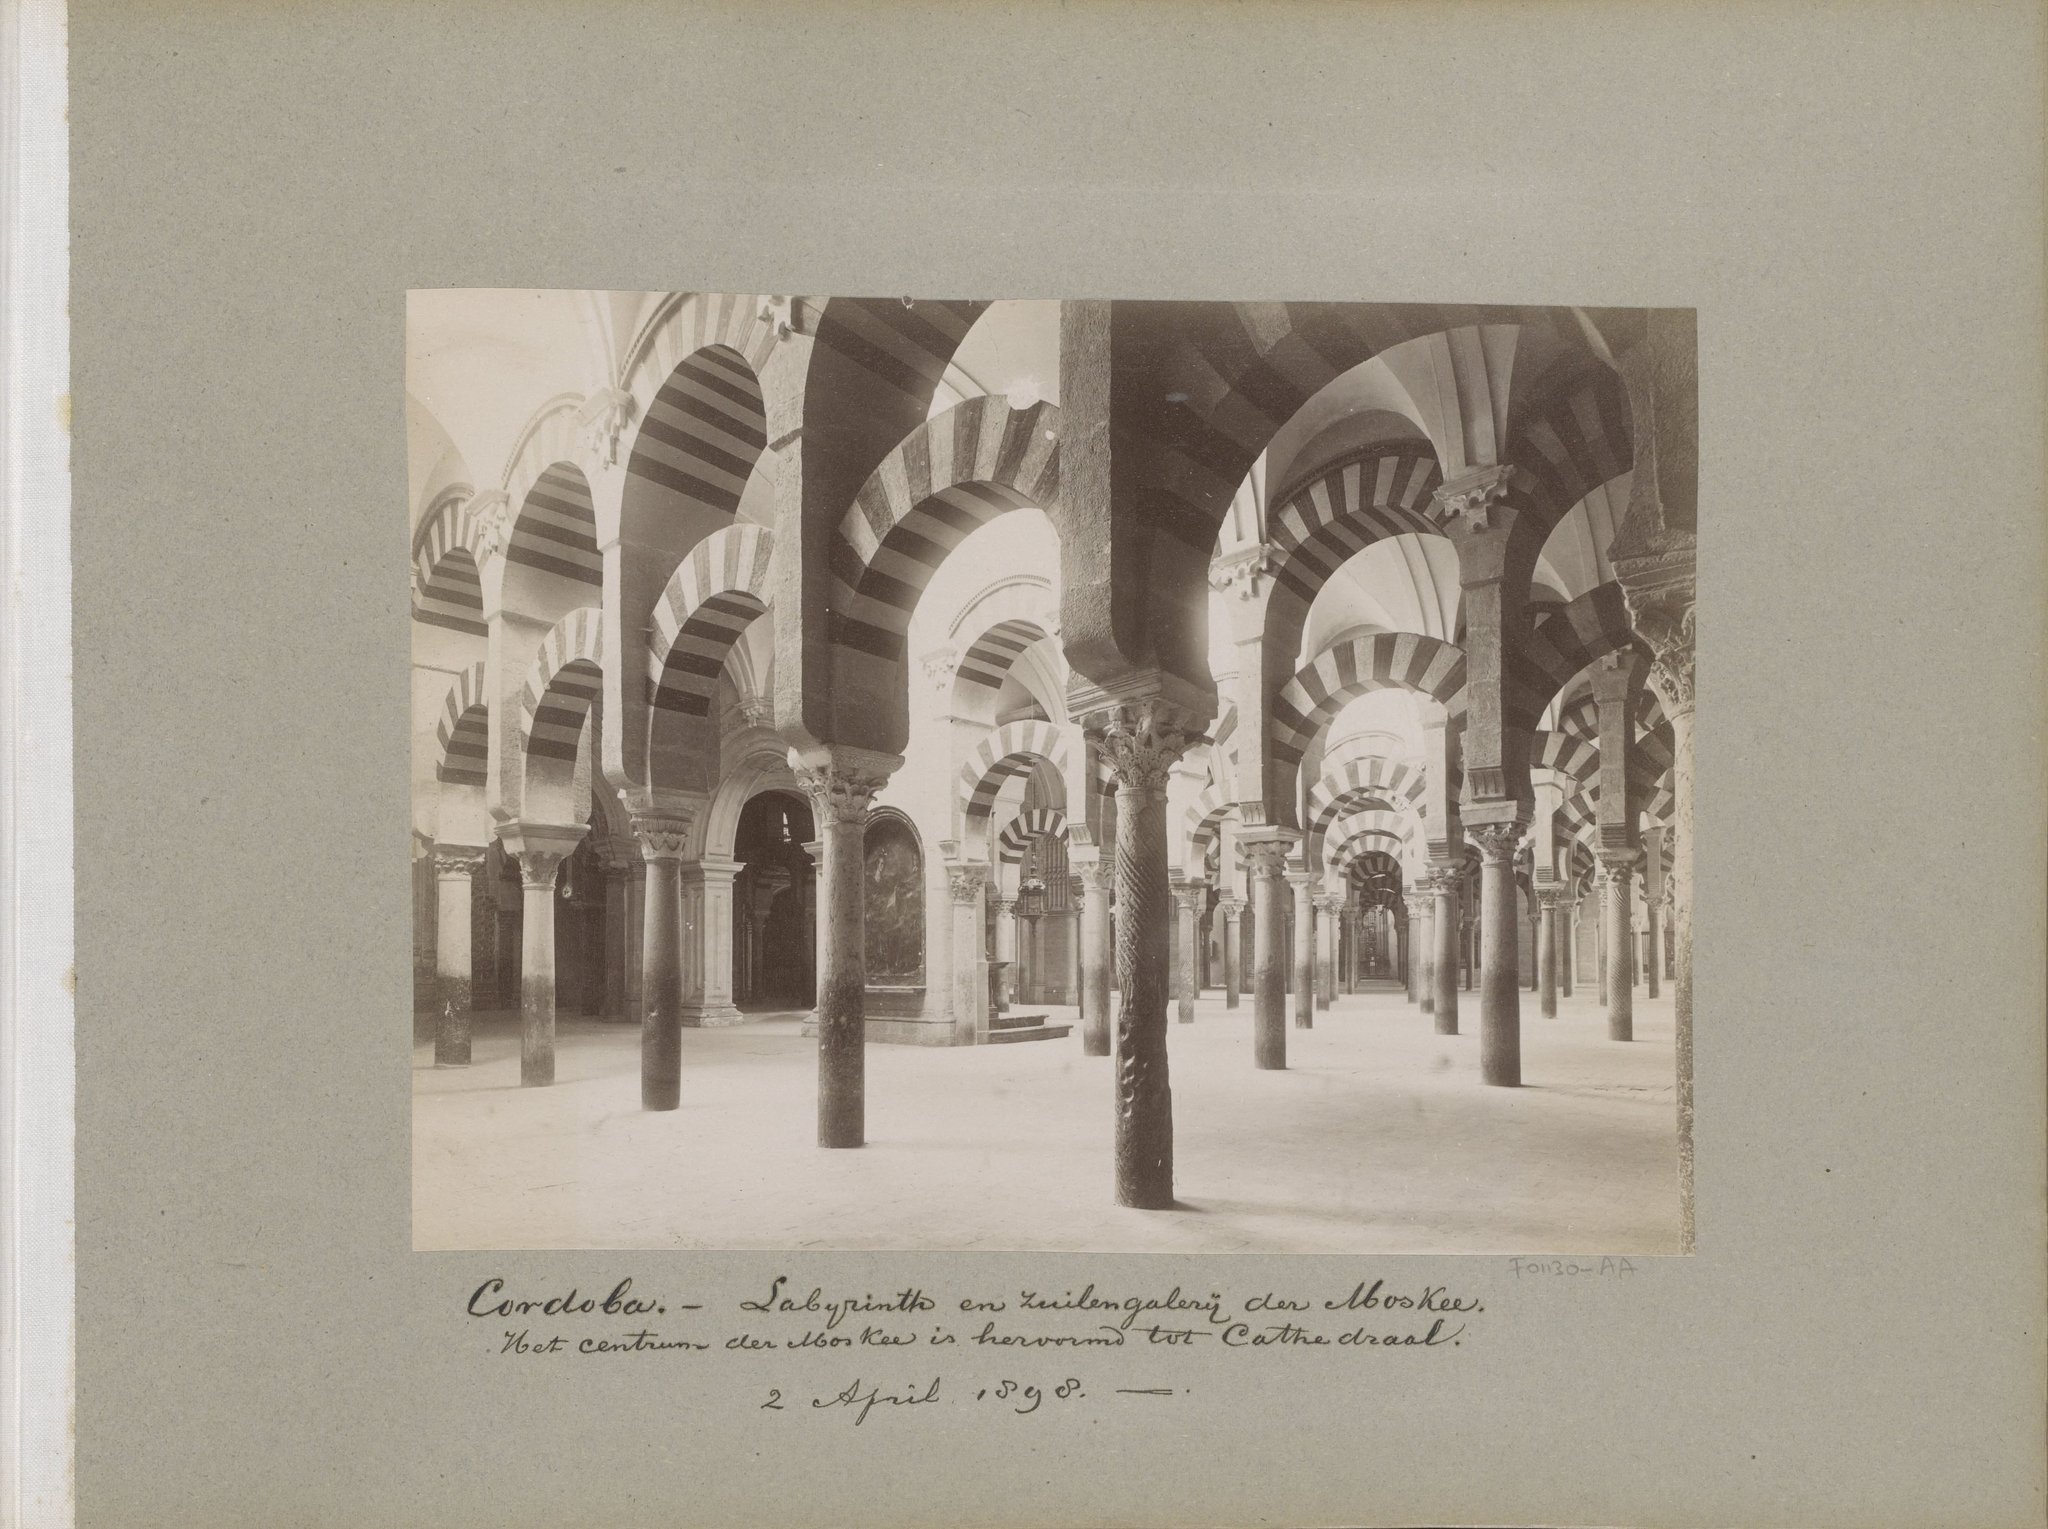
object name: album leaf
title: Zuilengalerij in de kathedraal van Córdoba (Mezquita)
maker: Anonymous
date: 1880-1898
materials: paper, photographic support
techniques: albumen print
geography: córdoba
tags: colonnade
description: Onderdeel van Reisalbum met foto's van bezienswaardigheden in Frankrijk, Spanje, Italië, Duitsland, Zwitserland en Oostenrijk.